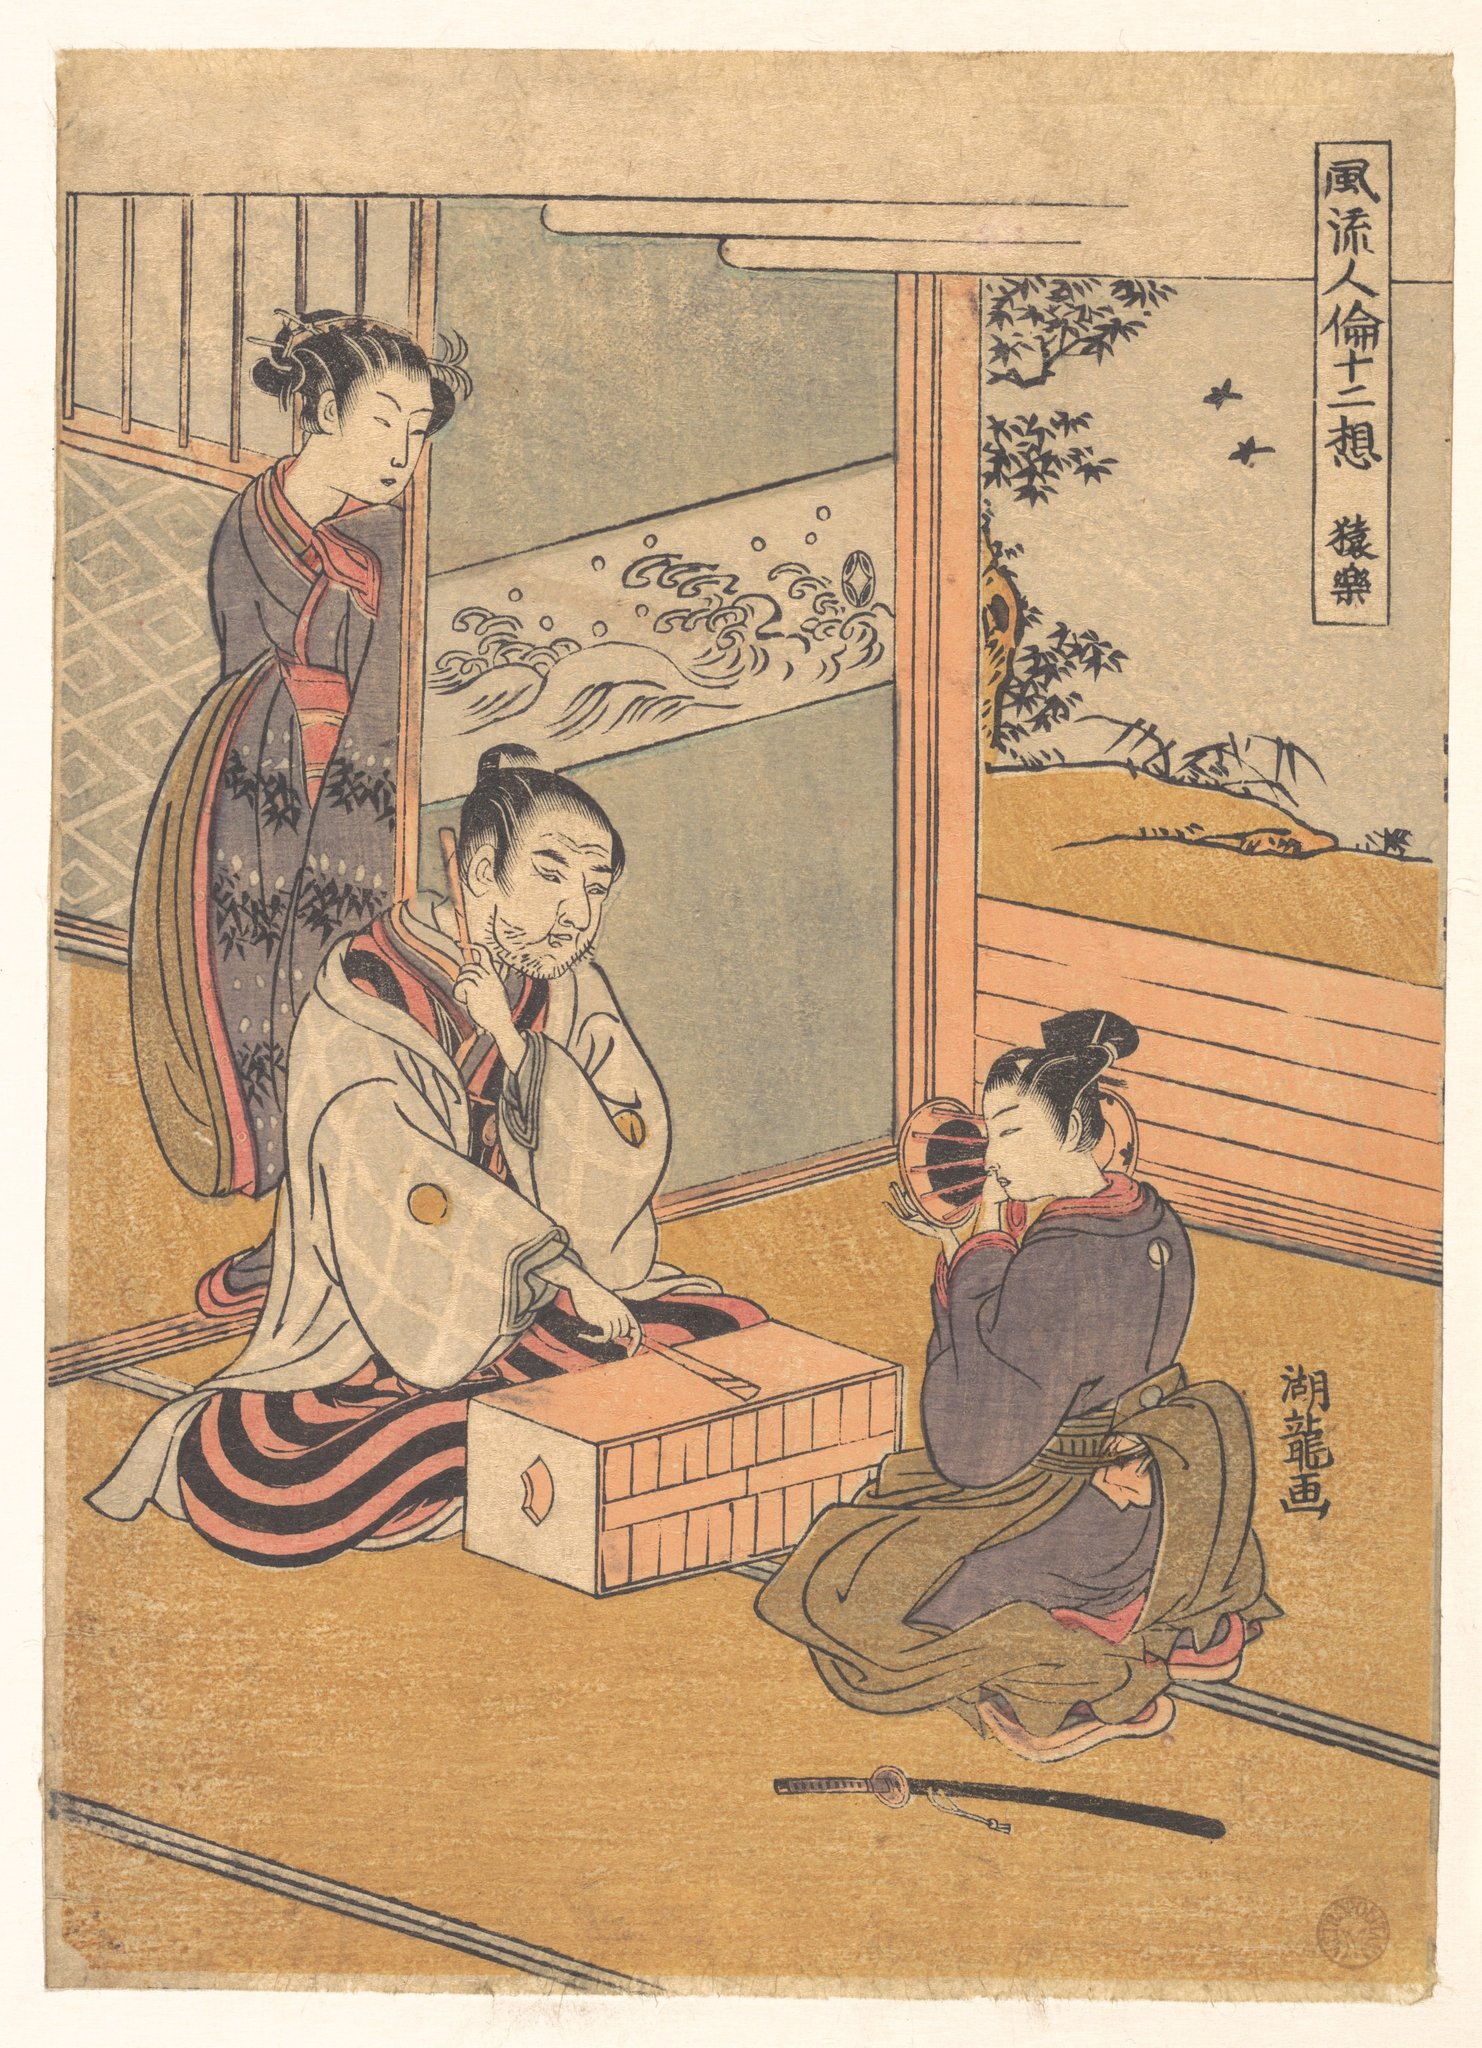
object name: print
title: Monkey Dance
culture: japanese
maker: isoda koryūsai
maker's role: artist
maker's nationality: japanese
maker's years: 1735-1790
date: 1760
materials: ink, paper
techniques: woodblock print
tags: men,women